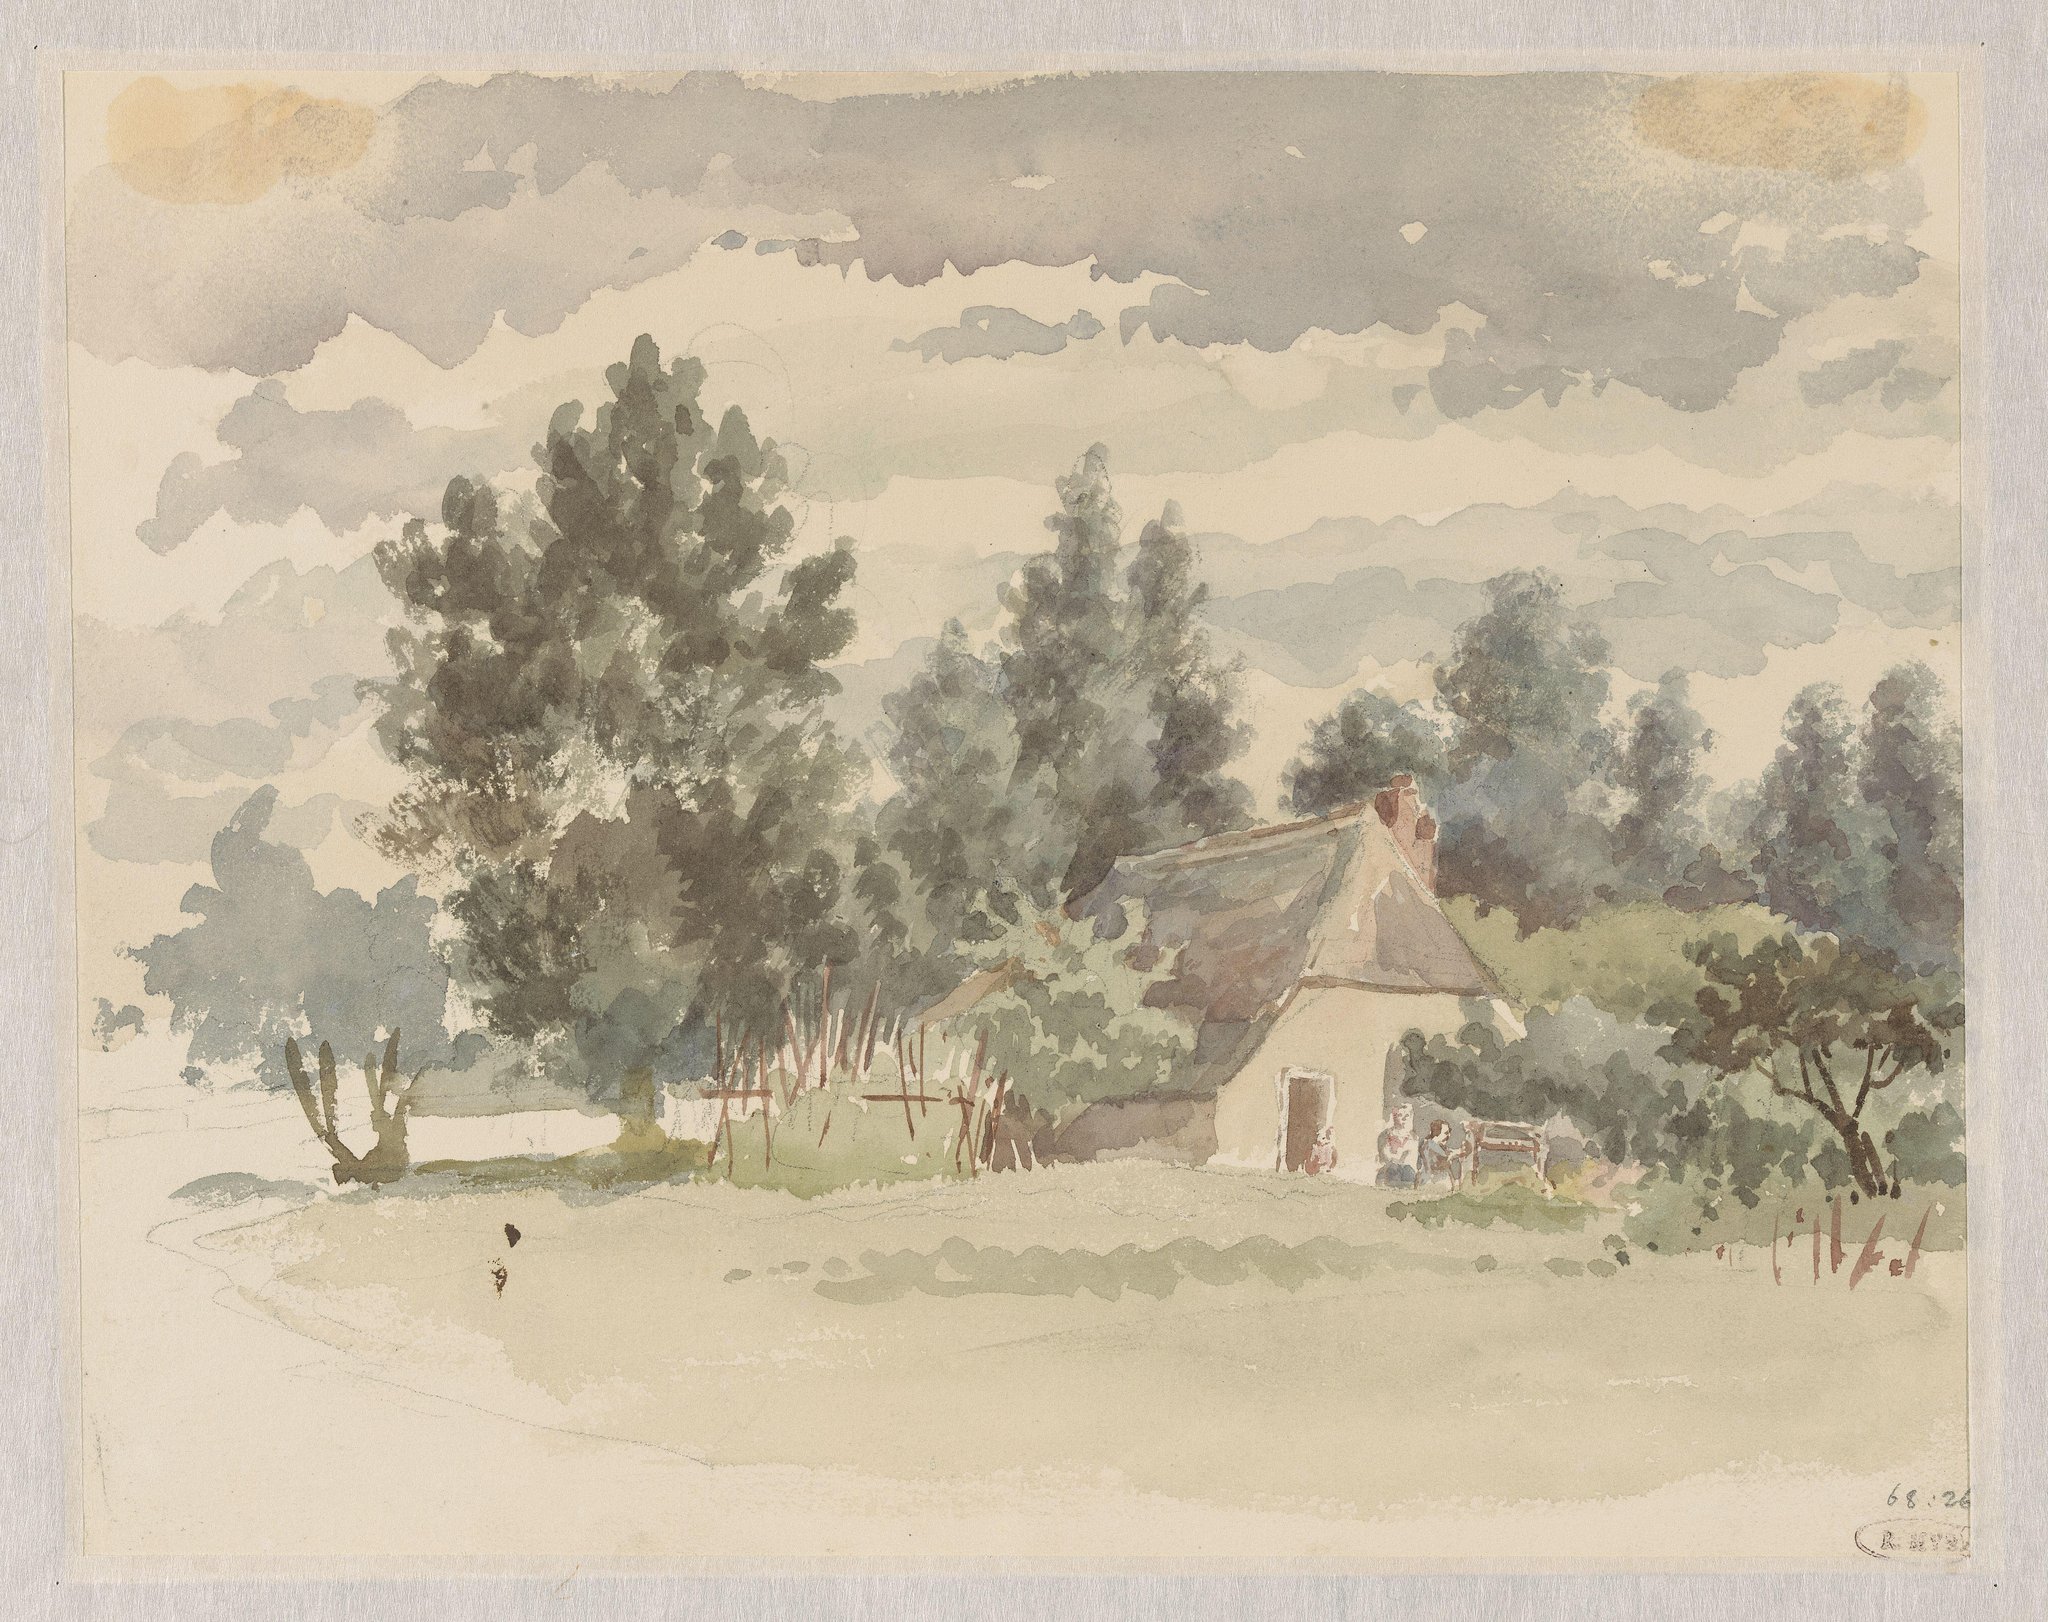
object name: drawing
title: Landschap met boerderij omgeven door bomen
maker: jan striening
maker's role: draughtsman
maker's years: 1827-1903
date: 1866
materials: chalk, paper, watercolor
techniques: brush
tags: farm or solitary house in landscape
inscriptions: date